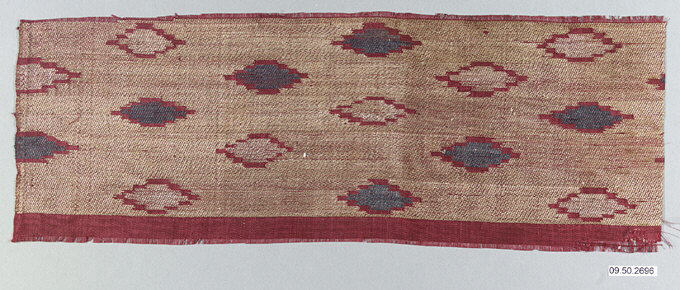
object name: textile fragment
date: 1701-1800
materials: metal thread, silk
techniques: brocade, satin weave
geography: turkey